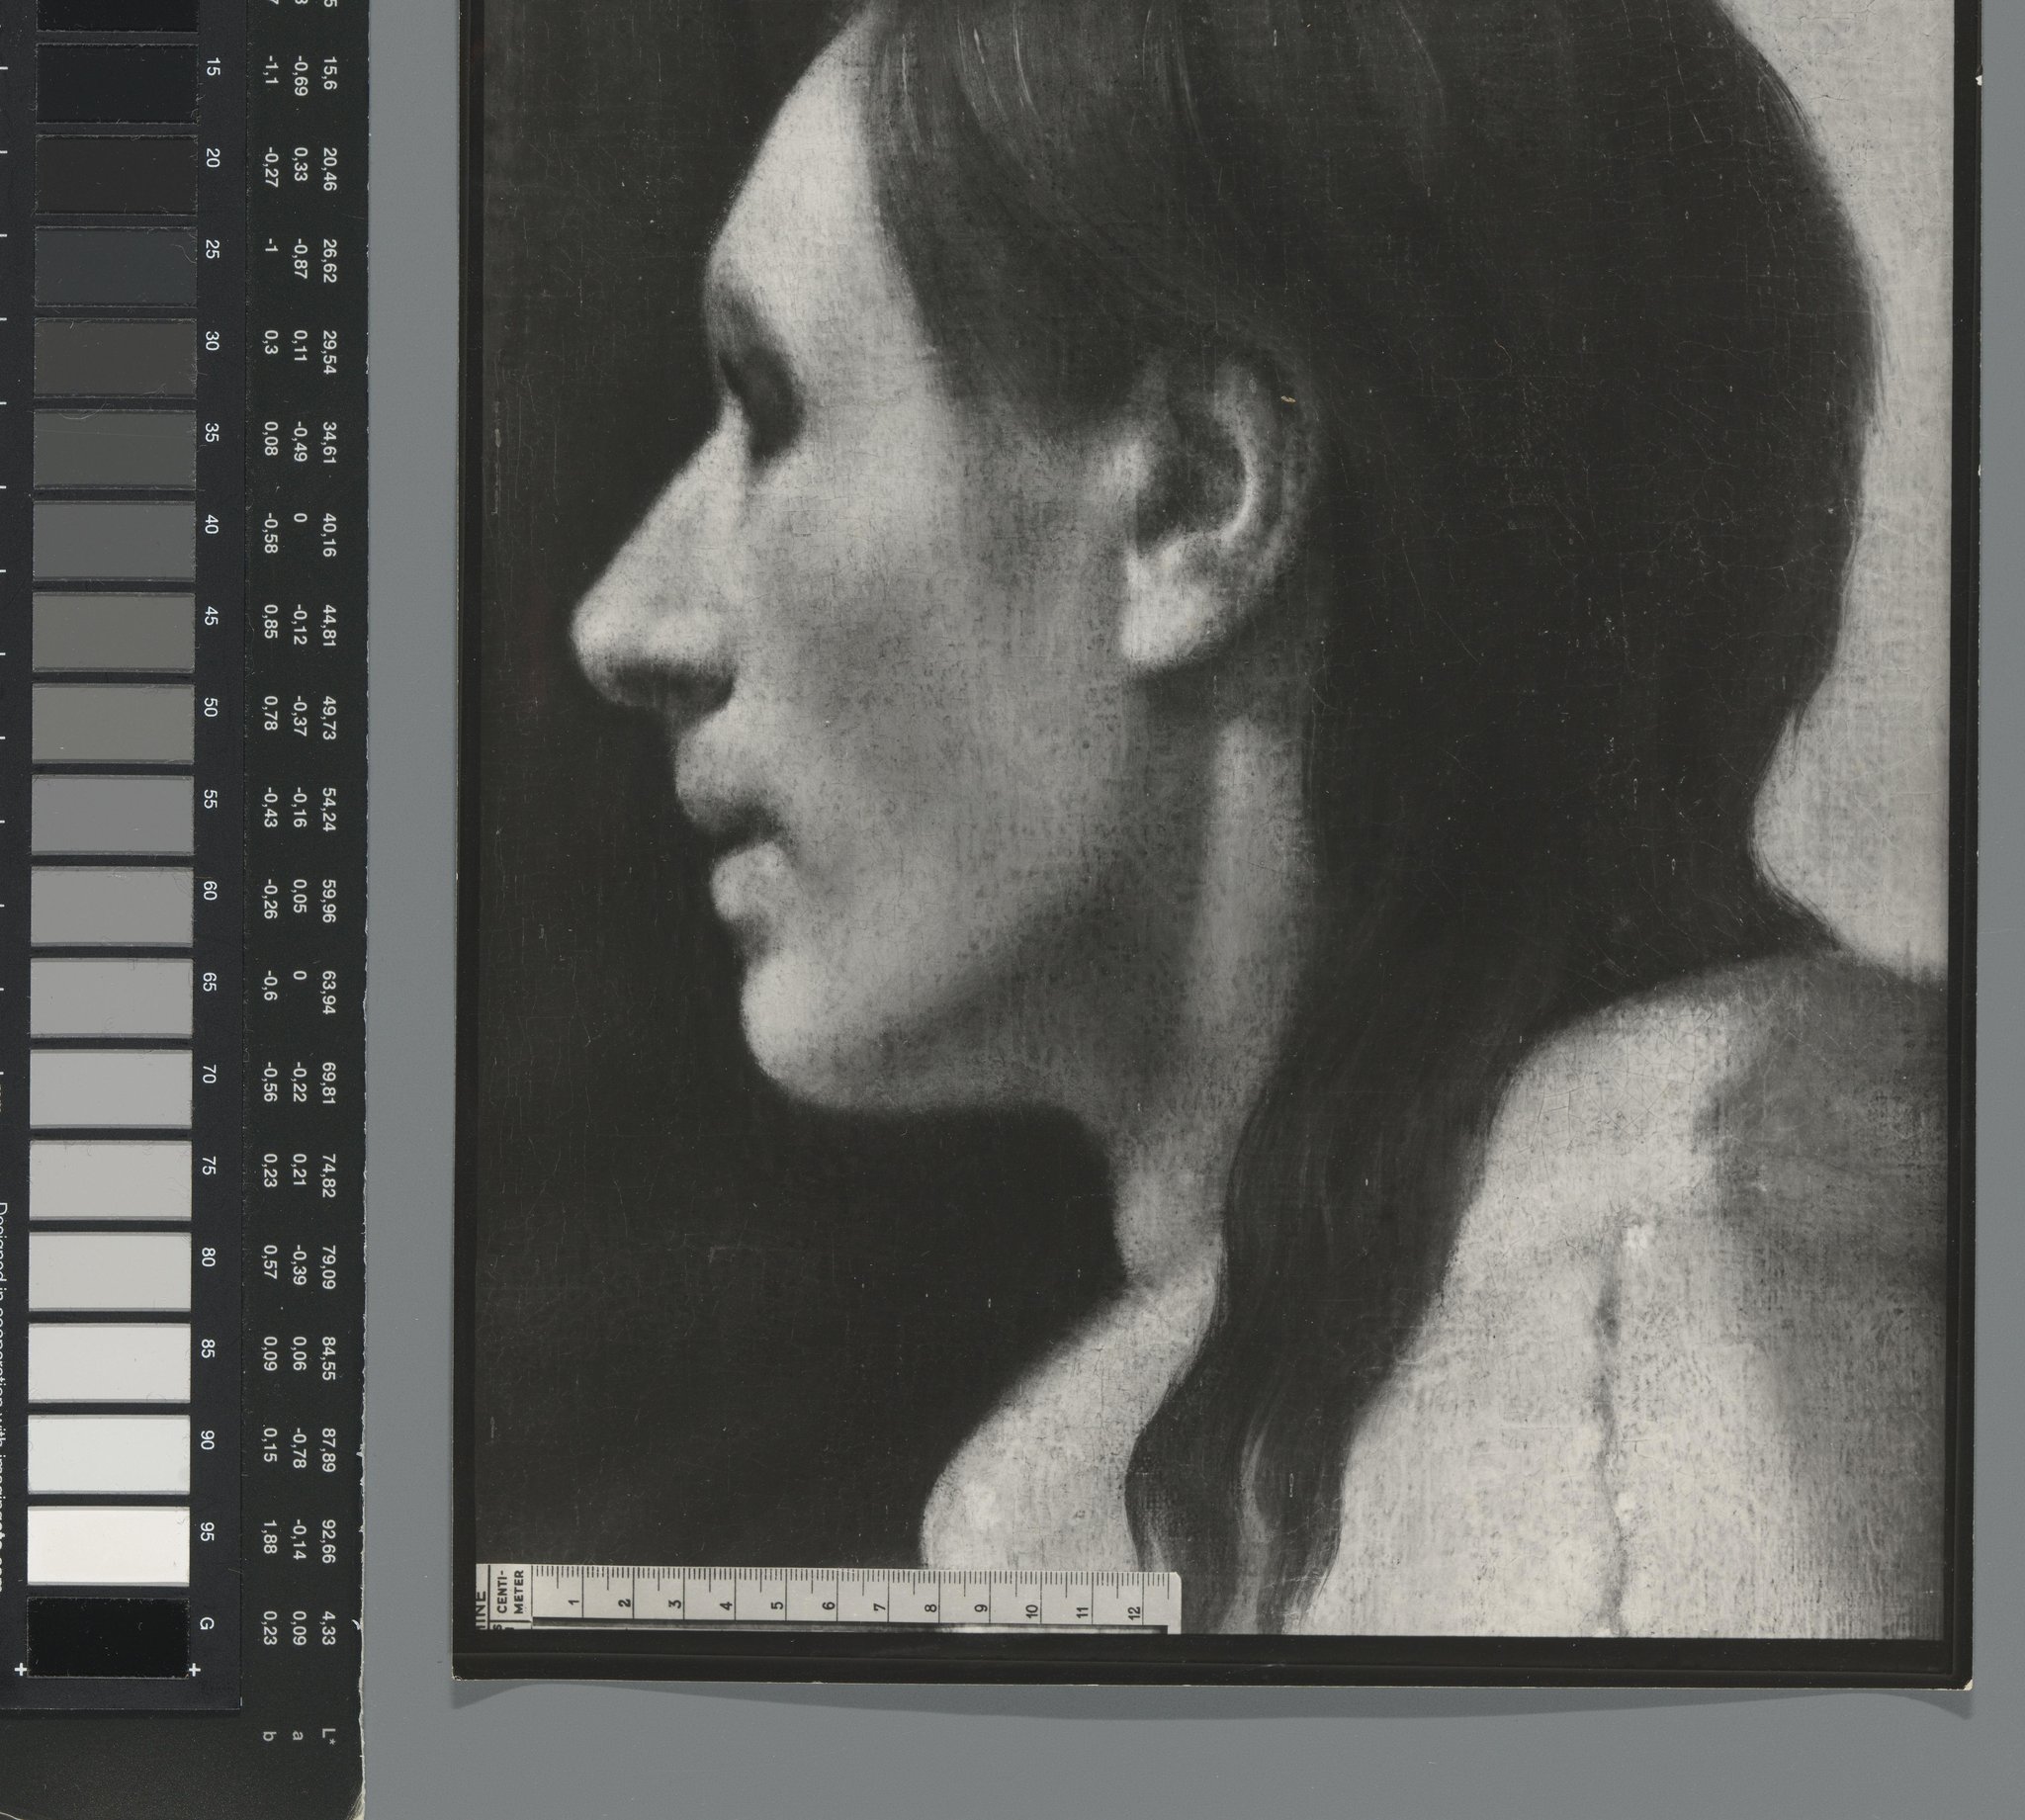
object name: photograph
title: Fotografische reproductie van een (detail) schilderij van Han van Meegeren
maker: nico zomer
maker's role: fotograaf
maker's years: 1910-1988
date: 1908-1948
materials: photographic support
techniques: gelatin silver print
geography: amsterdam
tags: picture, painting